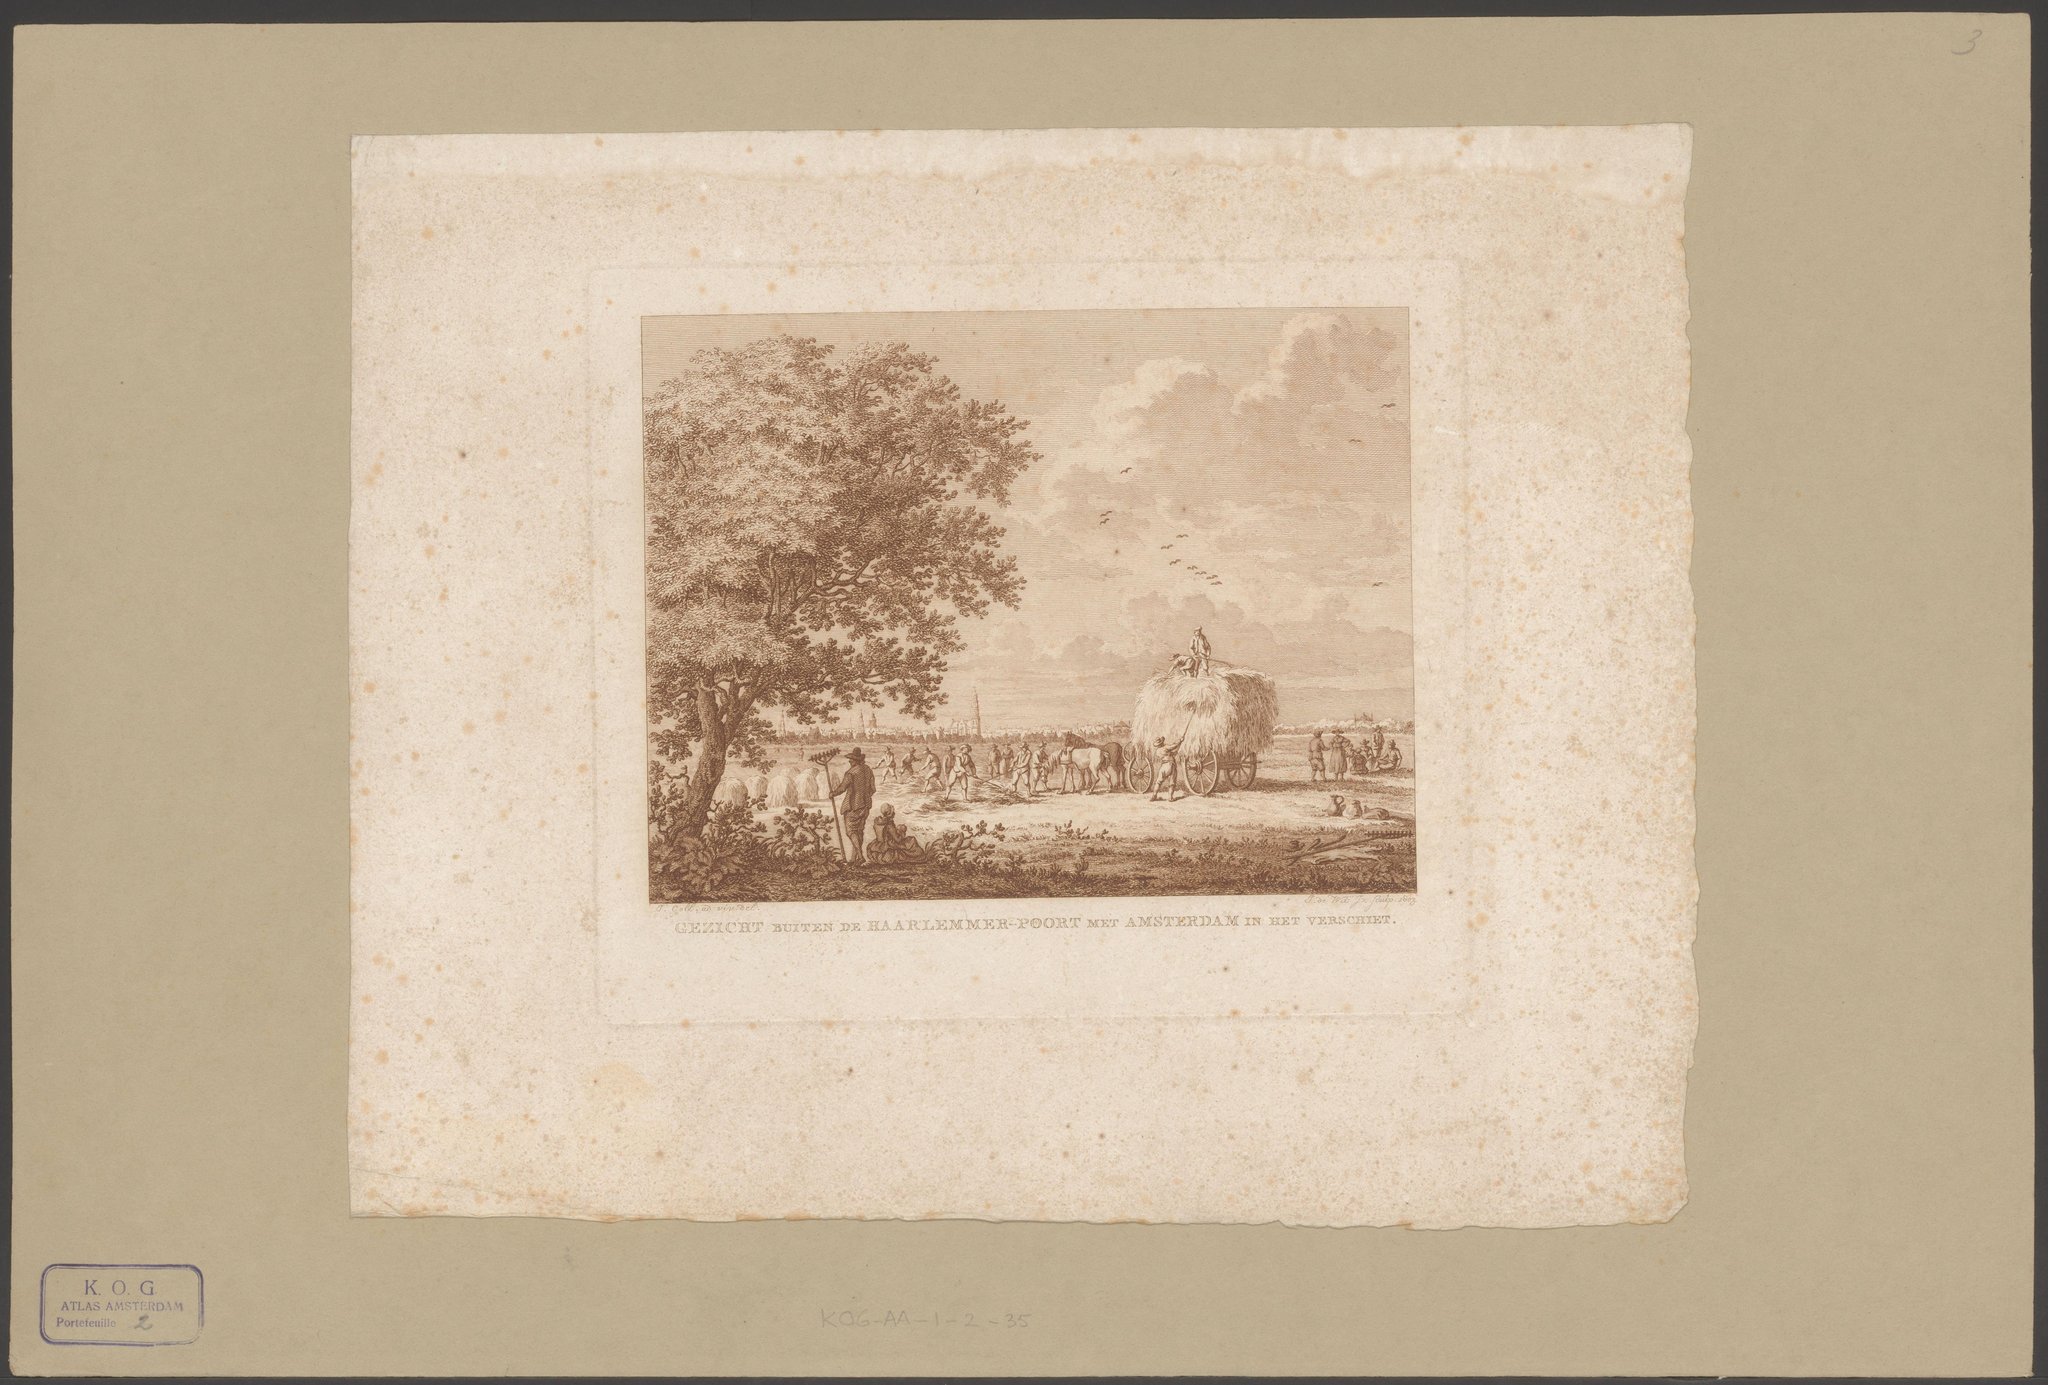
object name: print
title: Landschap met hooiende boeren met Amsterdam aan de horizon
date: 1803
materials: paper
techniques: etching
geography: haarlem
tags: agricultural products and by-products: hay, city-view in general; 'veduta', hay-stack, hay-wagon, agricultural implements: rake, amsterdam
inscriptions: collector's mark: ‘2’ Lugt 1641b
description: Onderwerpsrubriek binnen de Atlas Amsterdam: Gezichten op de stad uit het Westen / Buiten de Haarlemmerpoort.